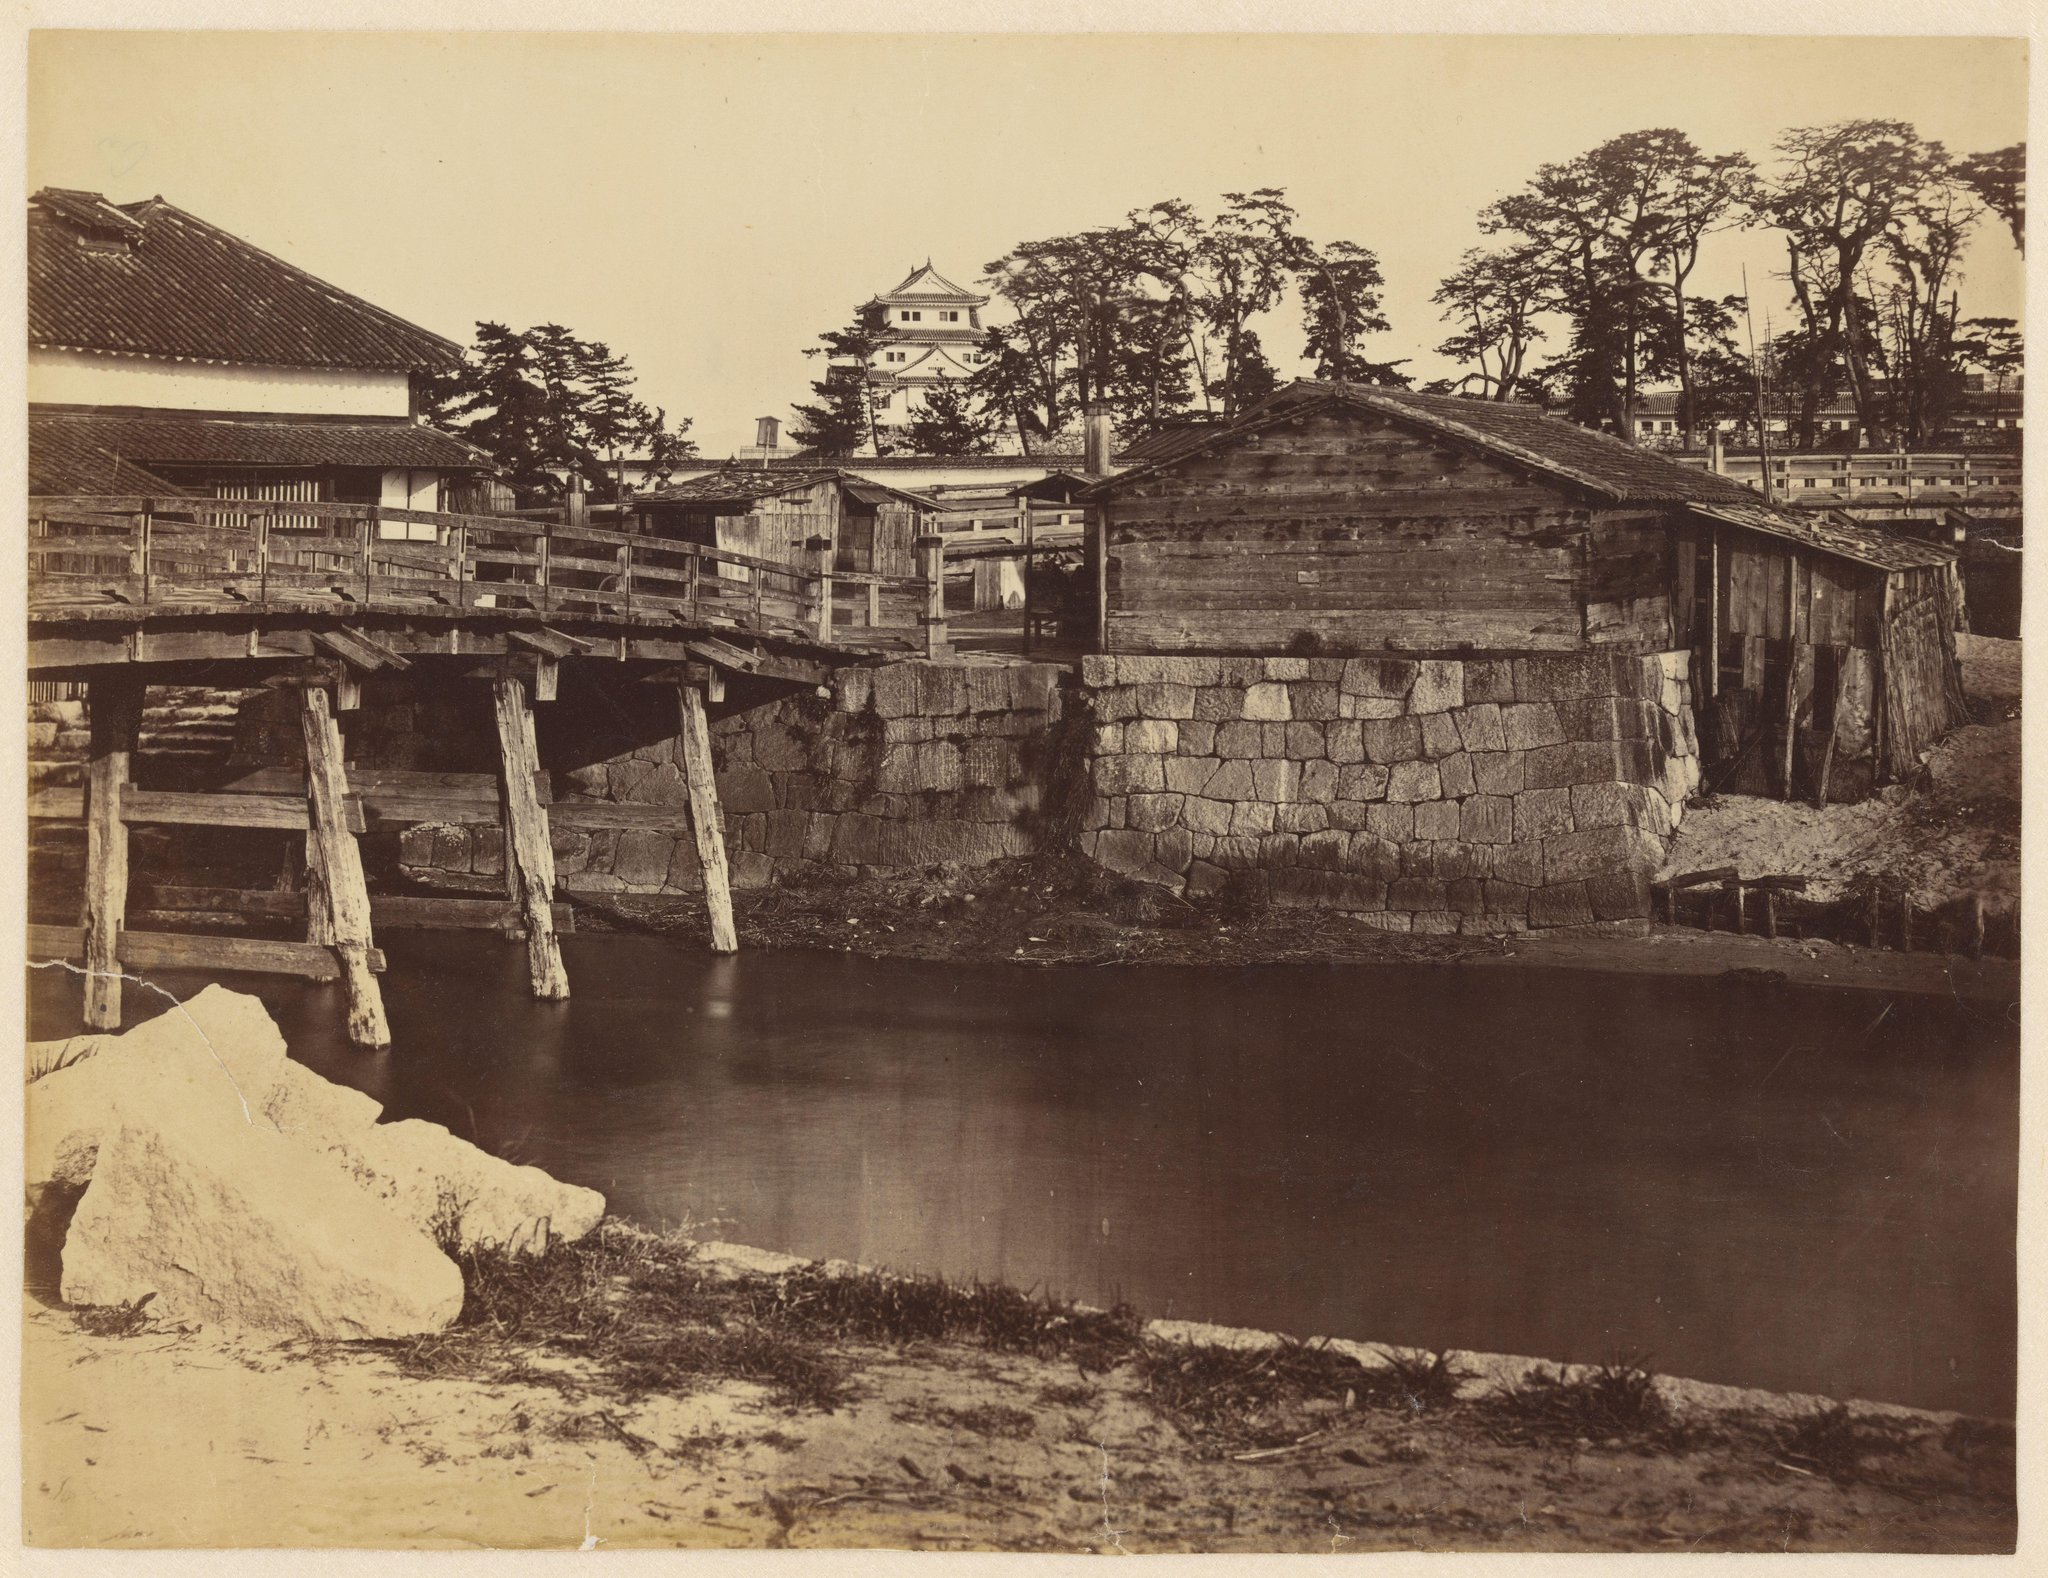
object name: photograph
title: Osaka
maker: Anonymous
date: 1865-1870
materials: paper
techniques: albumen print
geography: japan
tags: osaka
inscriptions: number: ‘BL38’, number: ‘BD184’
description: Antoon seems to have given up photography after leaving Nagasaki. All of his photos can thus be dated to between 1862 and 1866. After that, if he wished to have a picture, he had to buy what other photographers – professionals – deemed worthwhile and saleable. This put him in the same position as anyone else travelling or staying abroad at the time.